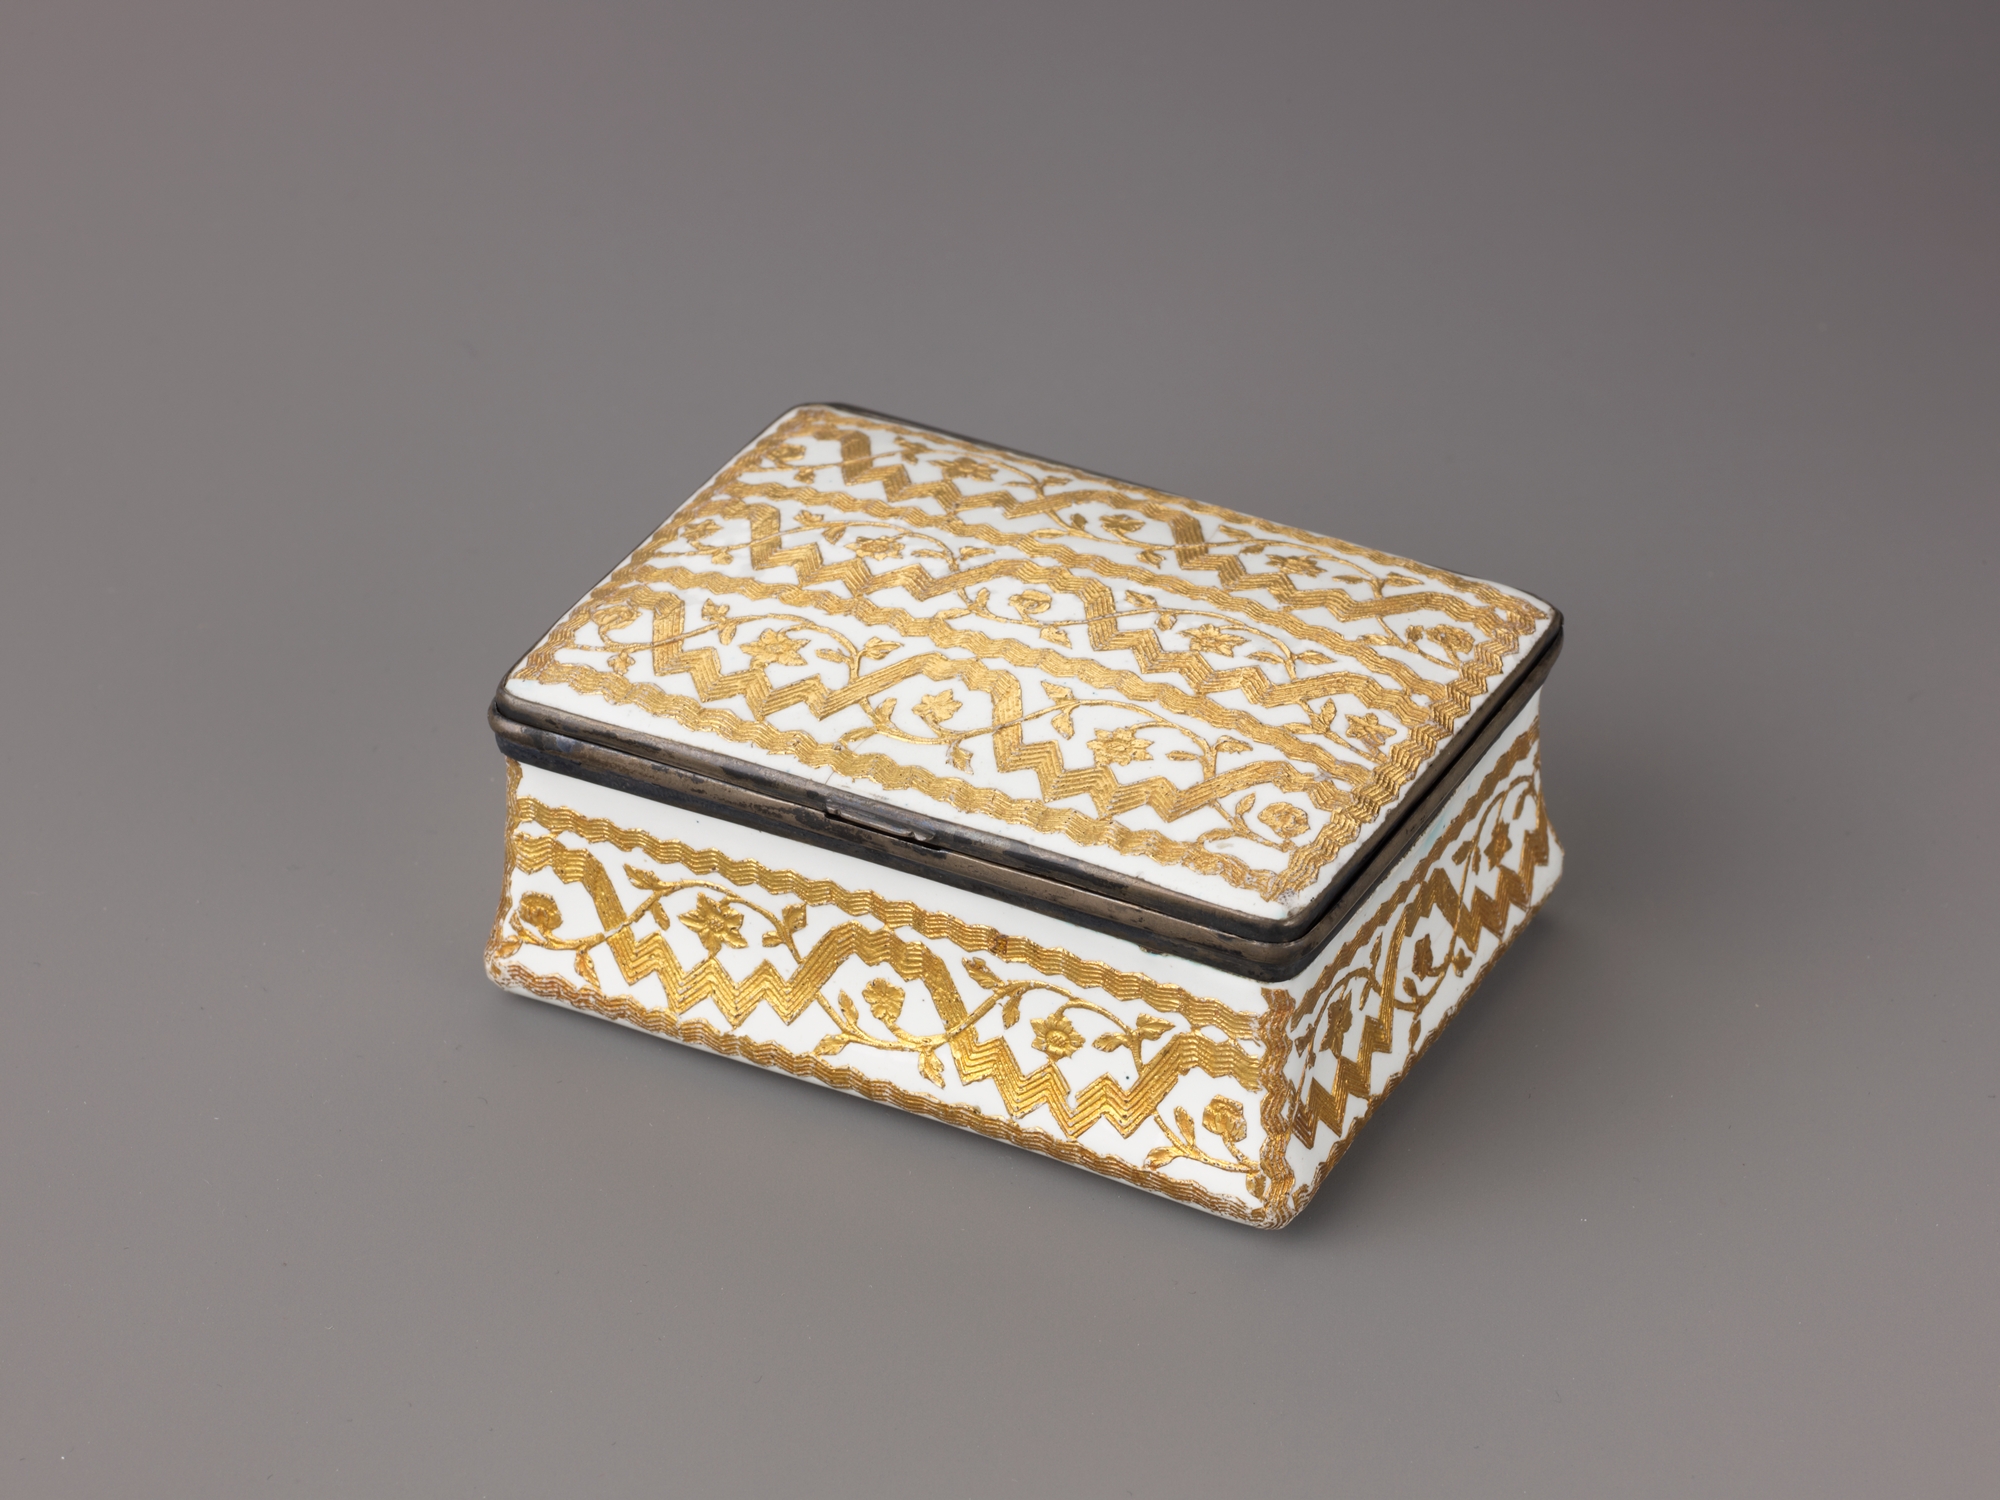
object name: snuffbox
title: Snuffbox with Trellis Patterns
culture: french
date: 1745-1750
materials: copper, silver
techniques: enamel